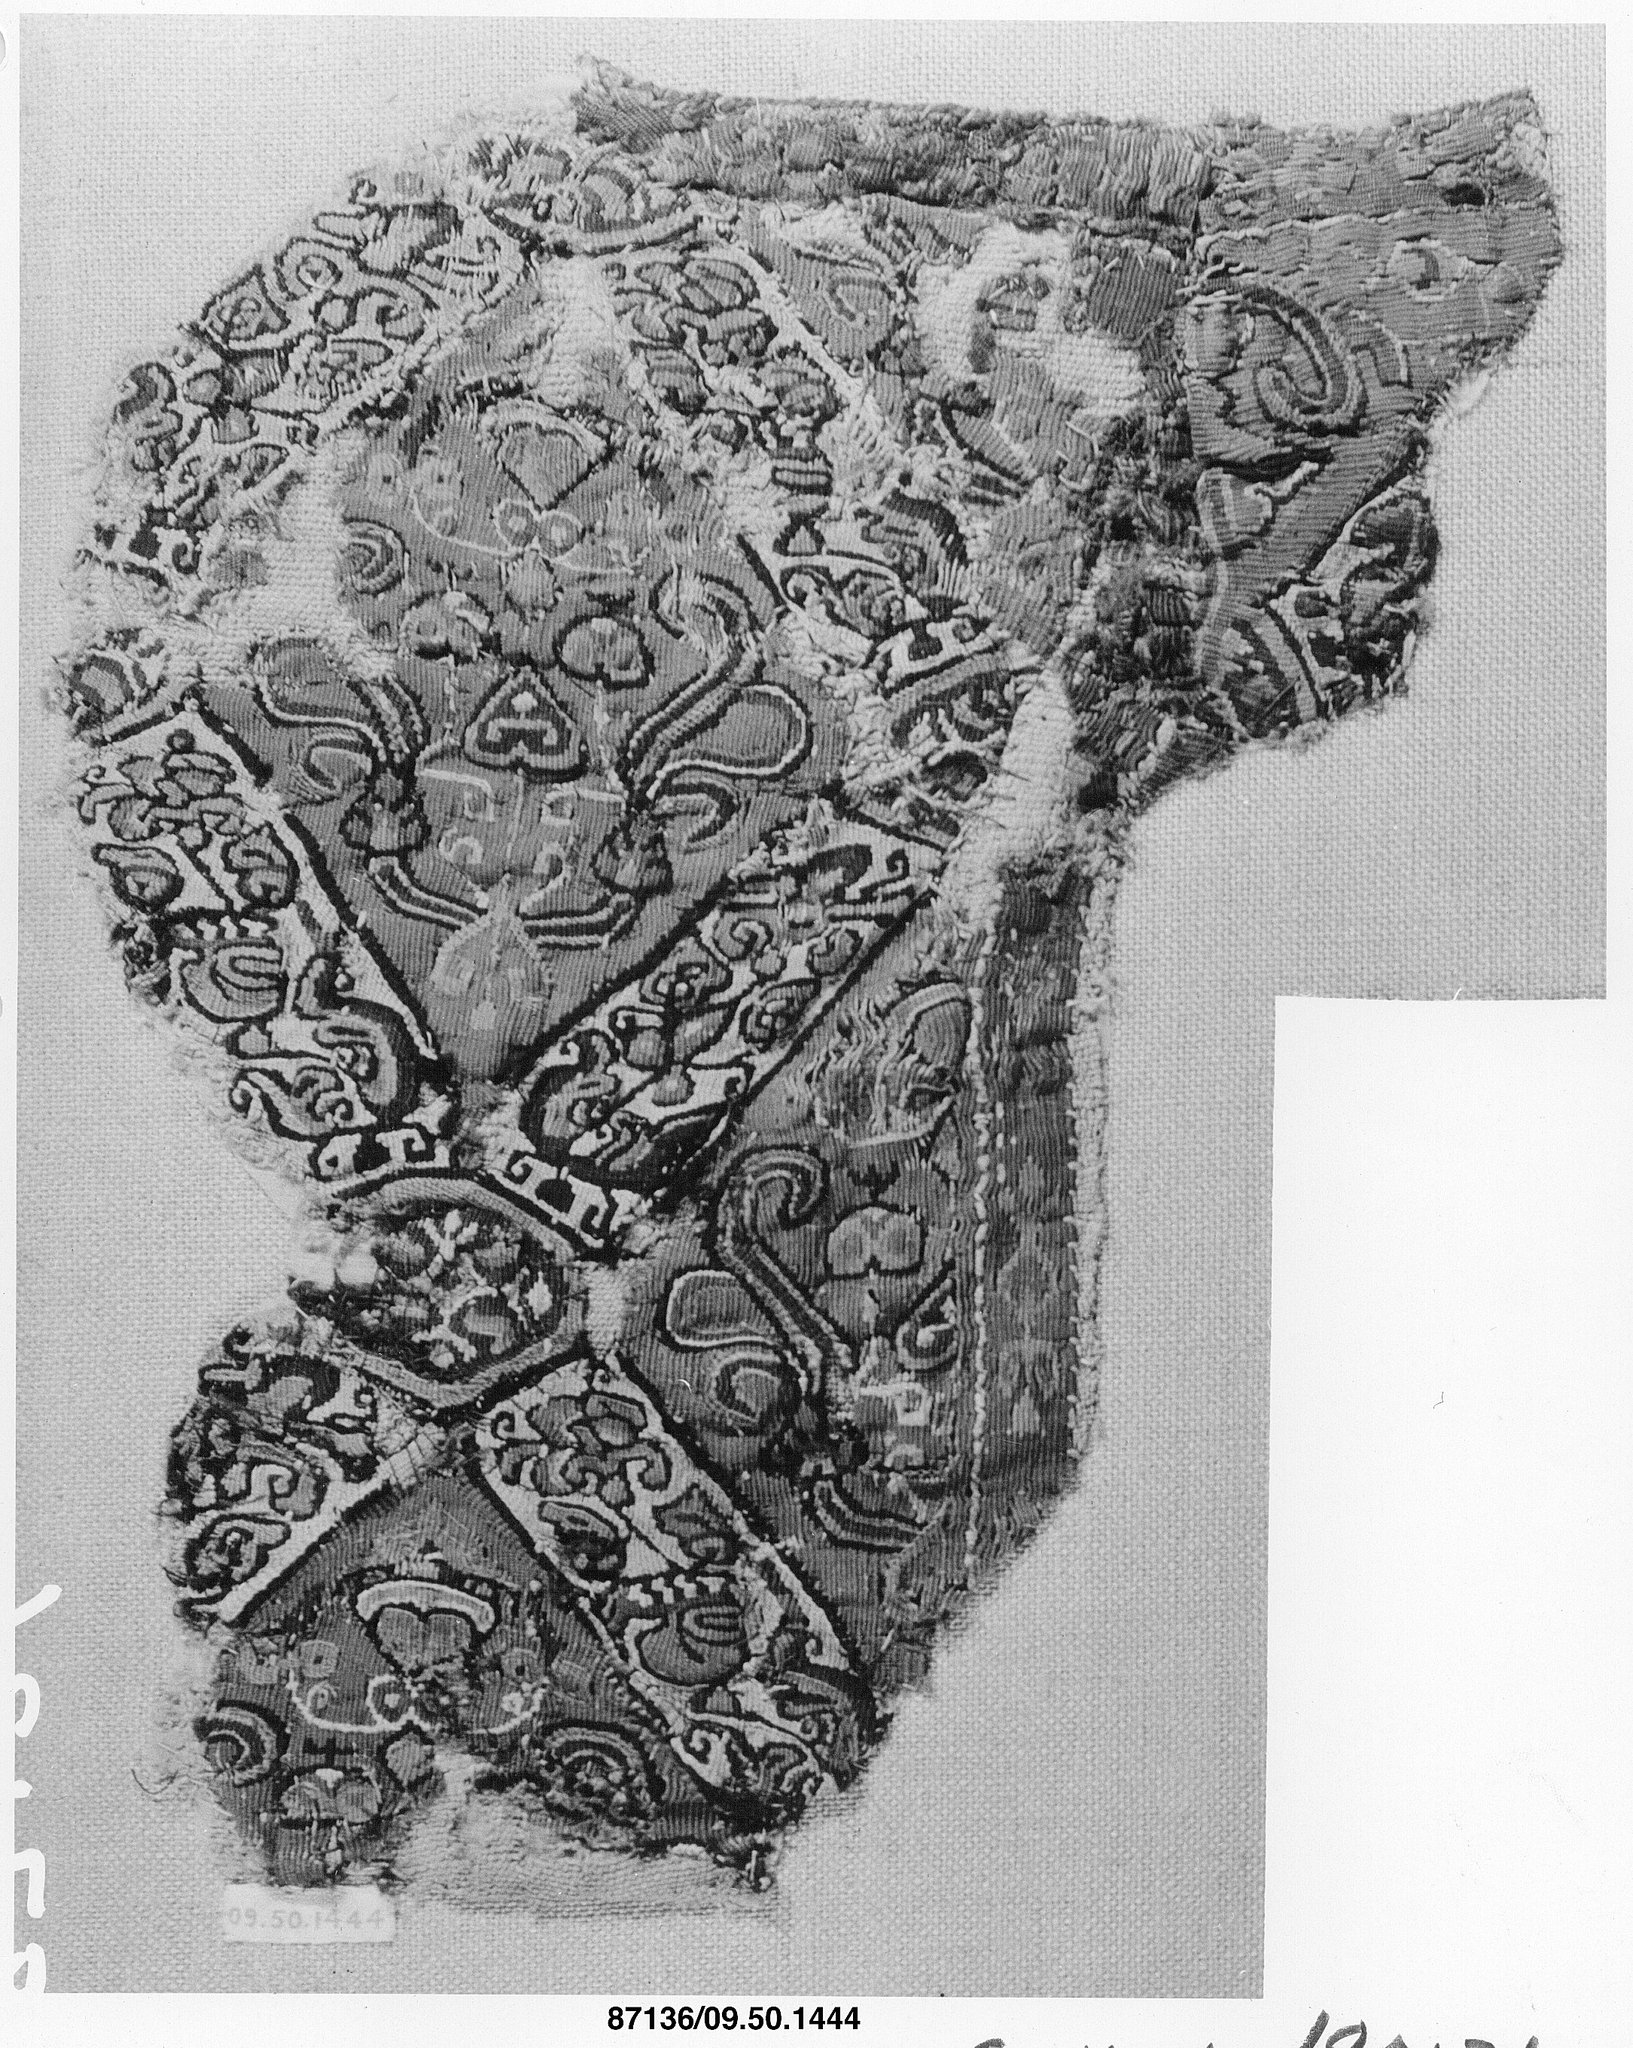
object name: textile fragment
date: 401-600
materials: linen, wool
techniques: weave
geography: egypt